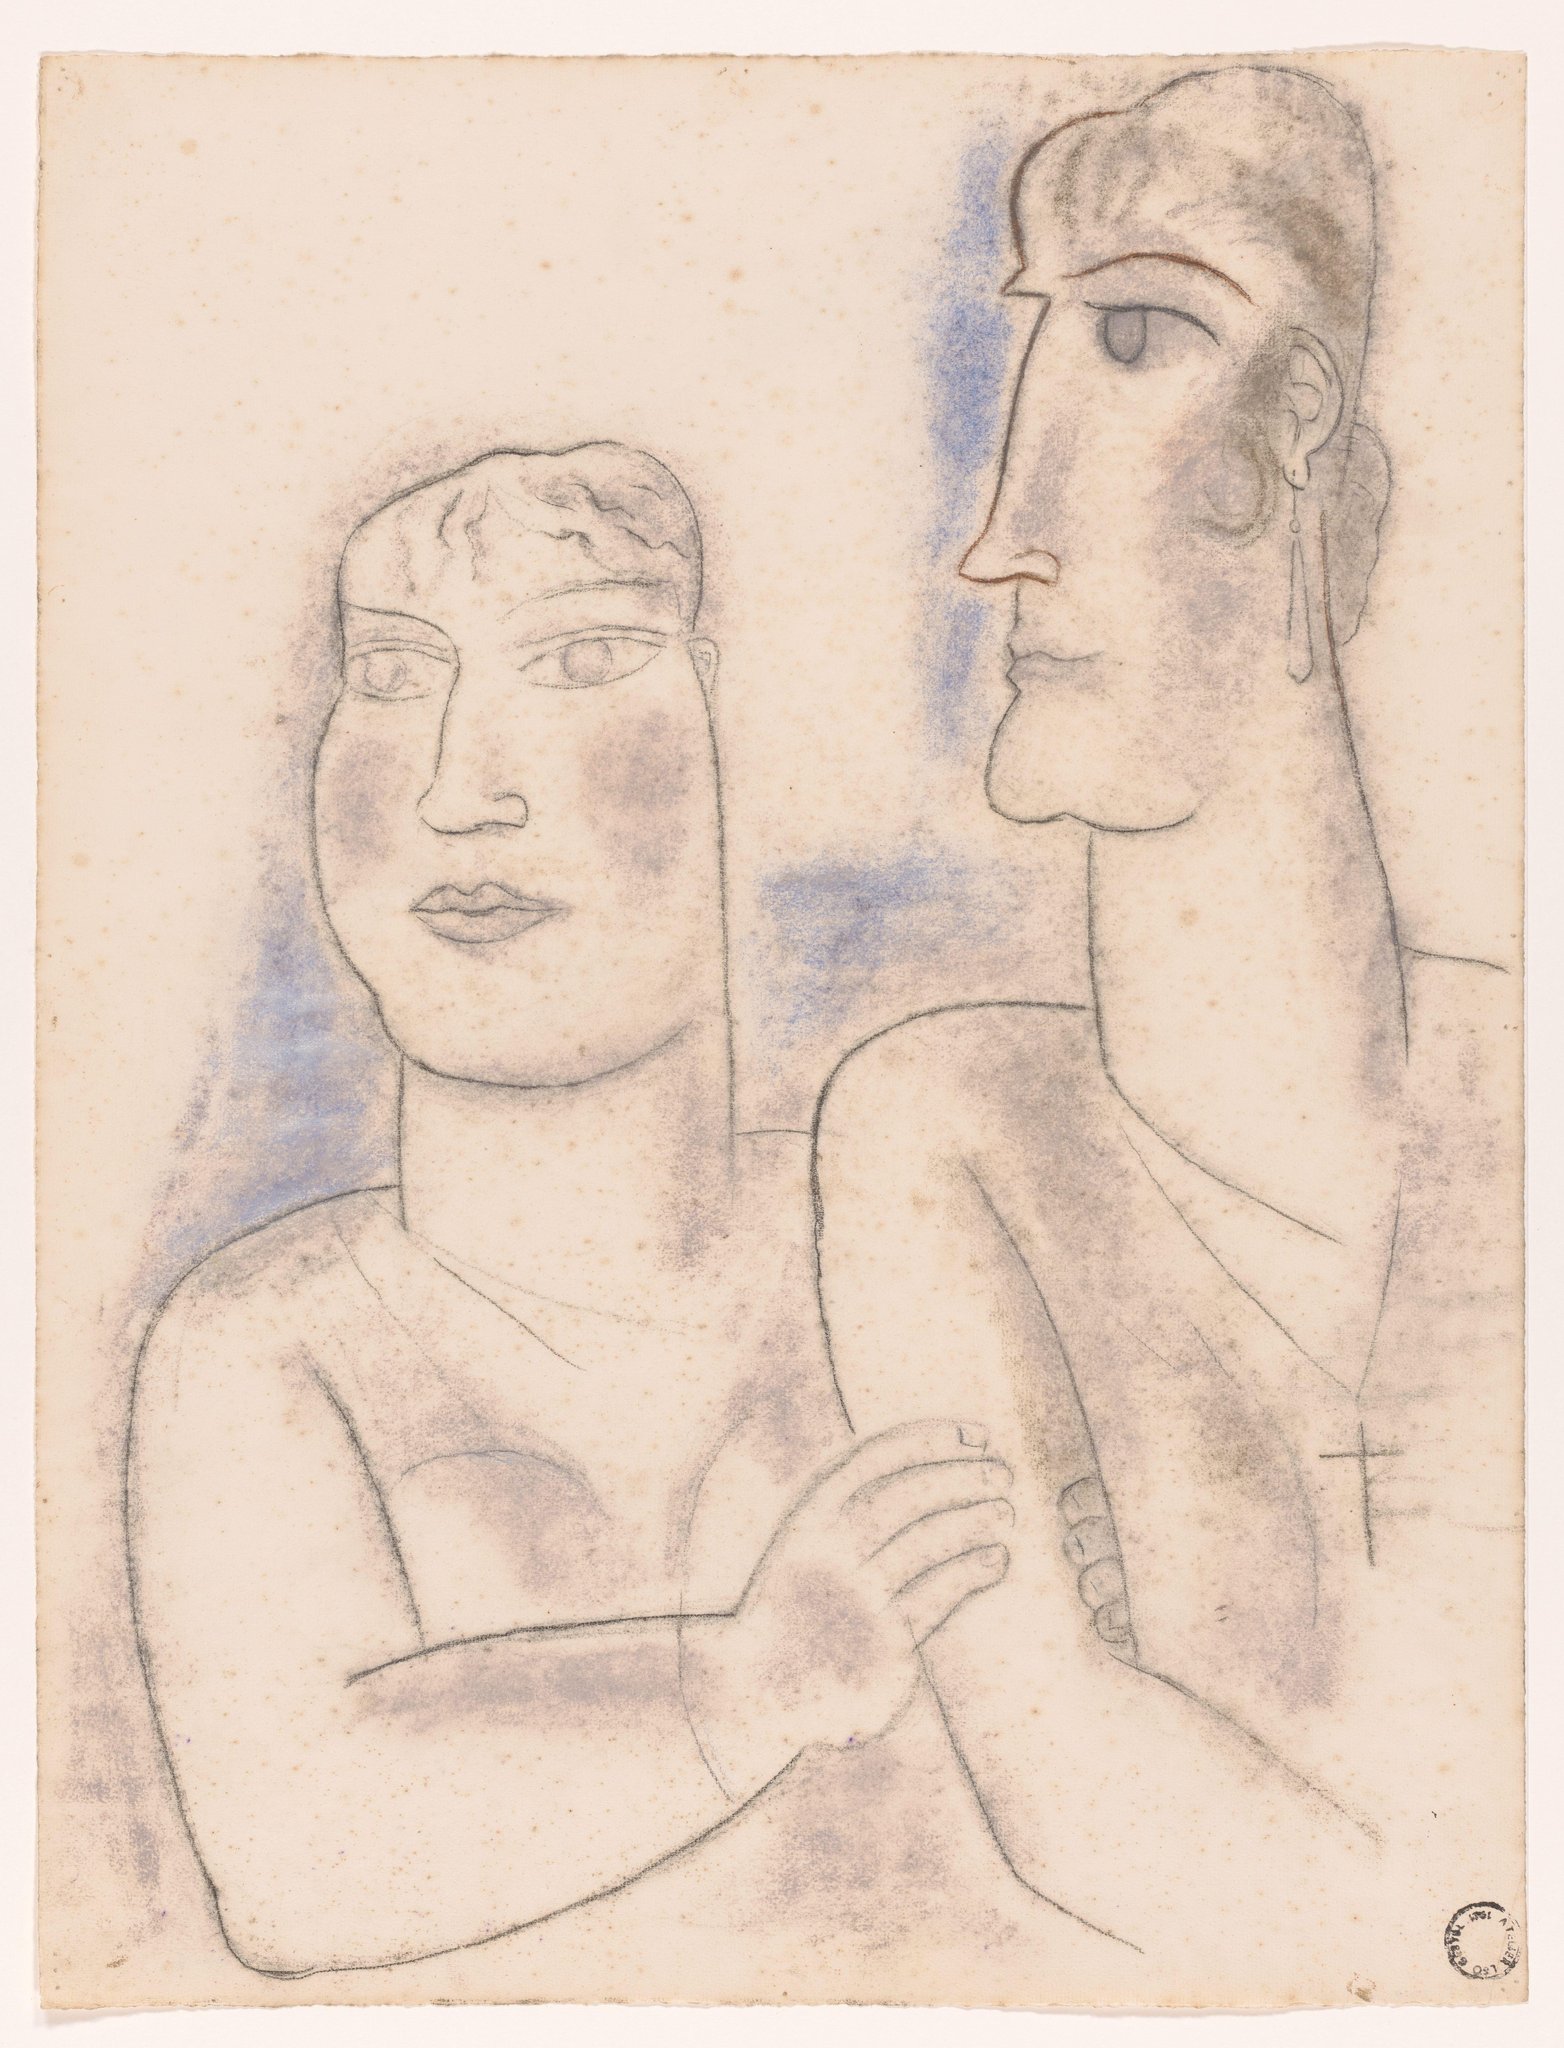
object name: drawing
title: Zonder titel Twee vrouwen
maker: leo gestel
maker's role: draughtsman, print maker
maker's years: 1881-1941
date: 1927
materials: chalk, paper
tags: adult woman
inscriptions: workshop stamp: Lugt 1078a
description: Twee vrouwen ten halven lijve, de rechter een druppelvormige oorbel dragend.